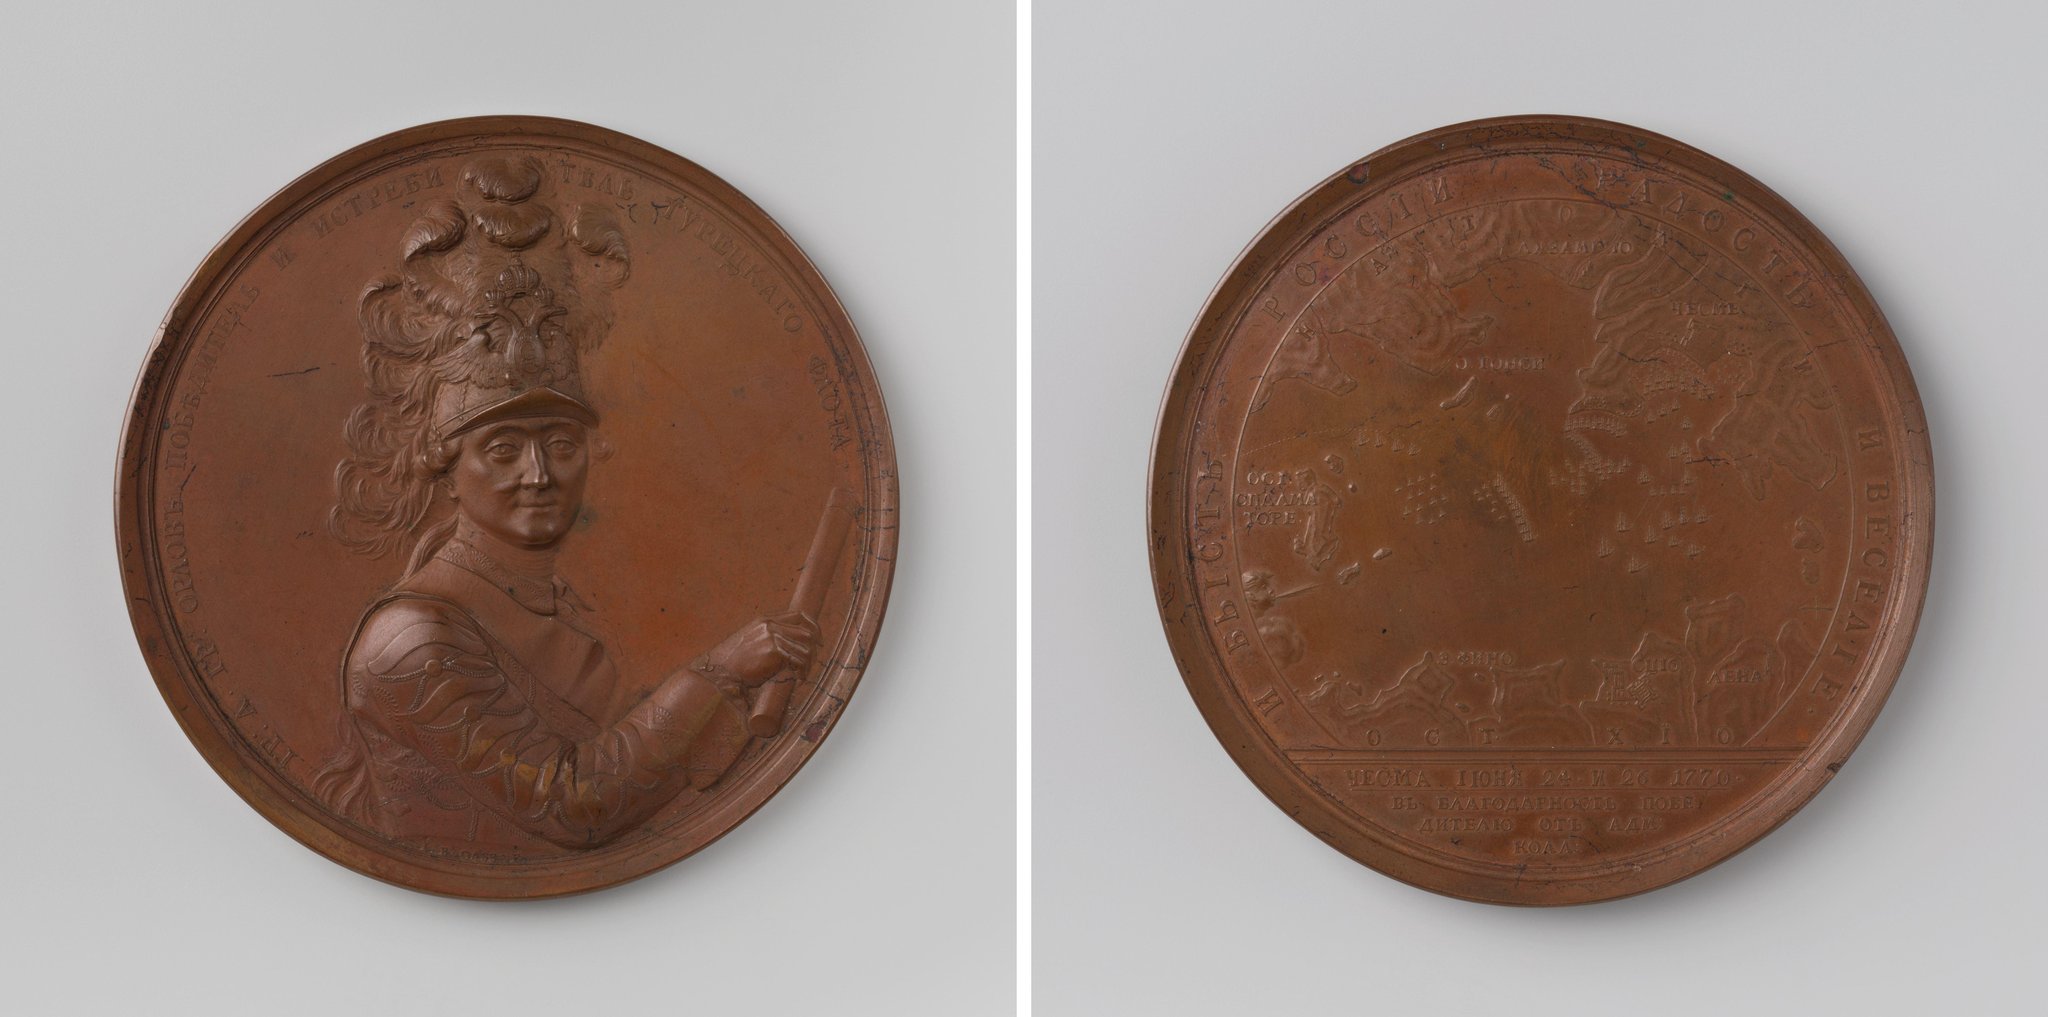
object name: history medal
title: Overwinning op de Turken in de slag van Cesme, penning door het college van de admiraliteit geschonken aan Aleksei Grigorjevitsj, graaf Orlov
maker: johann baptista gass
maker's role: medailleur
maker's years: 1768-1797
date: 1770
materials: bronze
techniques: striking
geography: sint-petersburg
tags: moskou, admiraal, aleksei grigorjevitsj graaf orlov, siberië, turkije, cesme, russisch-turkse oorlog (1768-1774), slag bij cesme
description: Bronzen penning. Voorzijde: borststuk man met gepluimde helm en commandostaf binnen omschrift. Keerzijde: landkaart met voorstelling van zeeslag binnen omschrift; afsnede: opschrift.